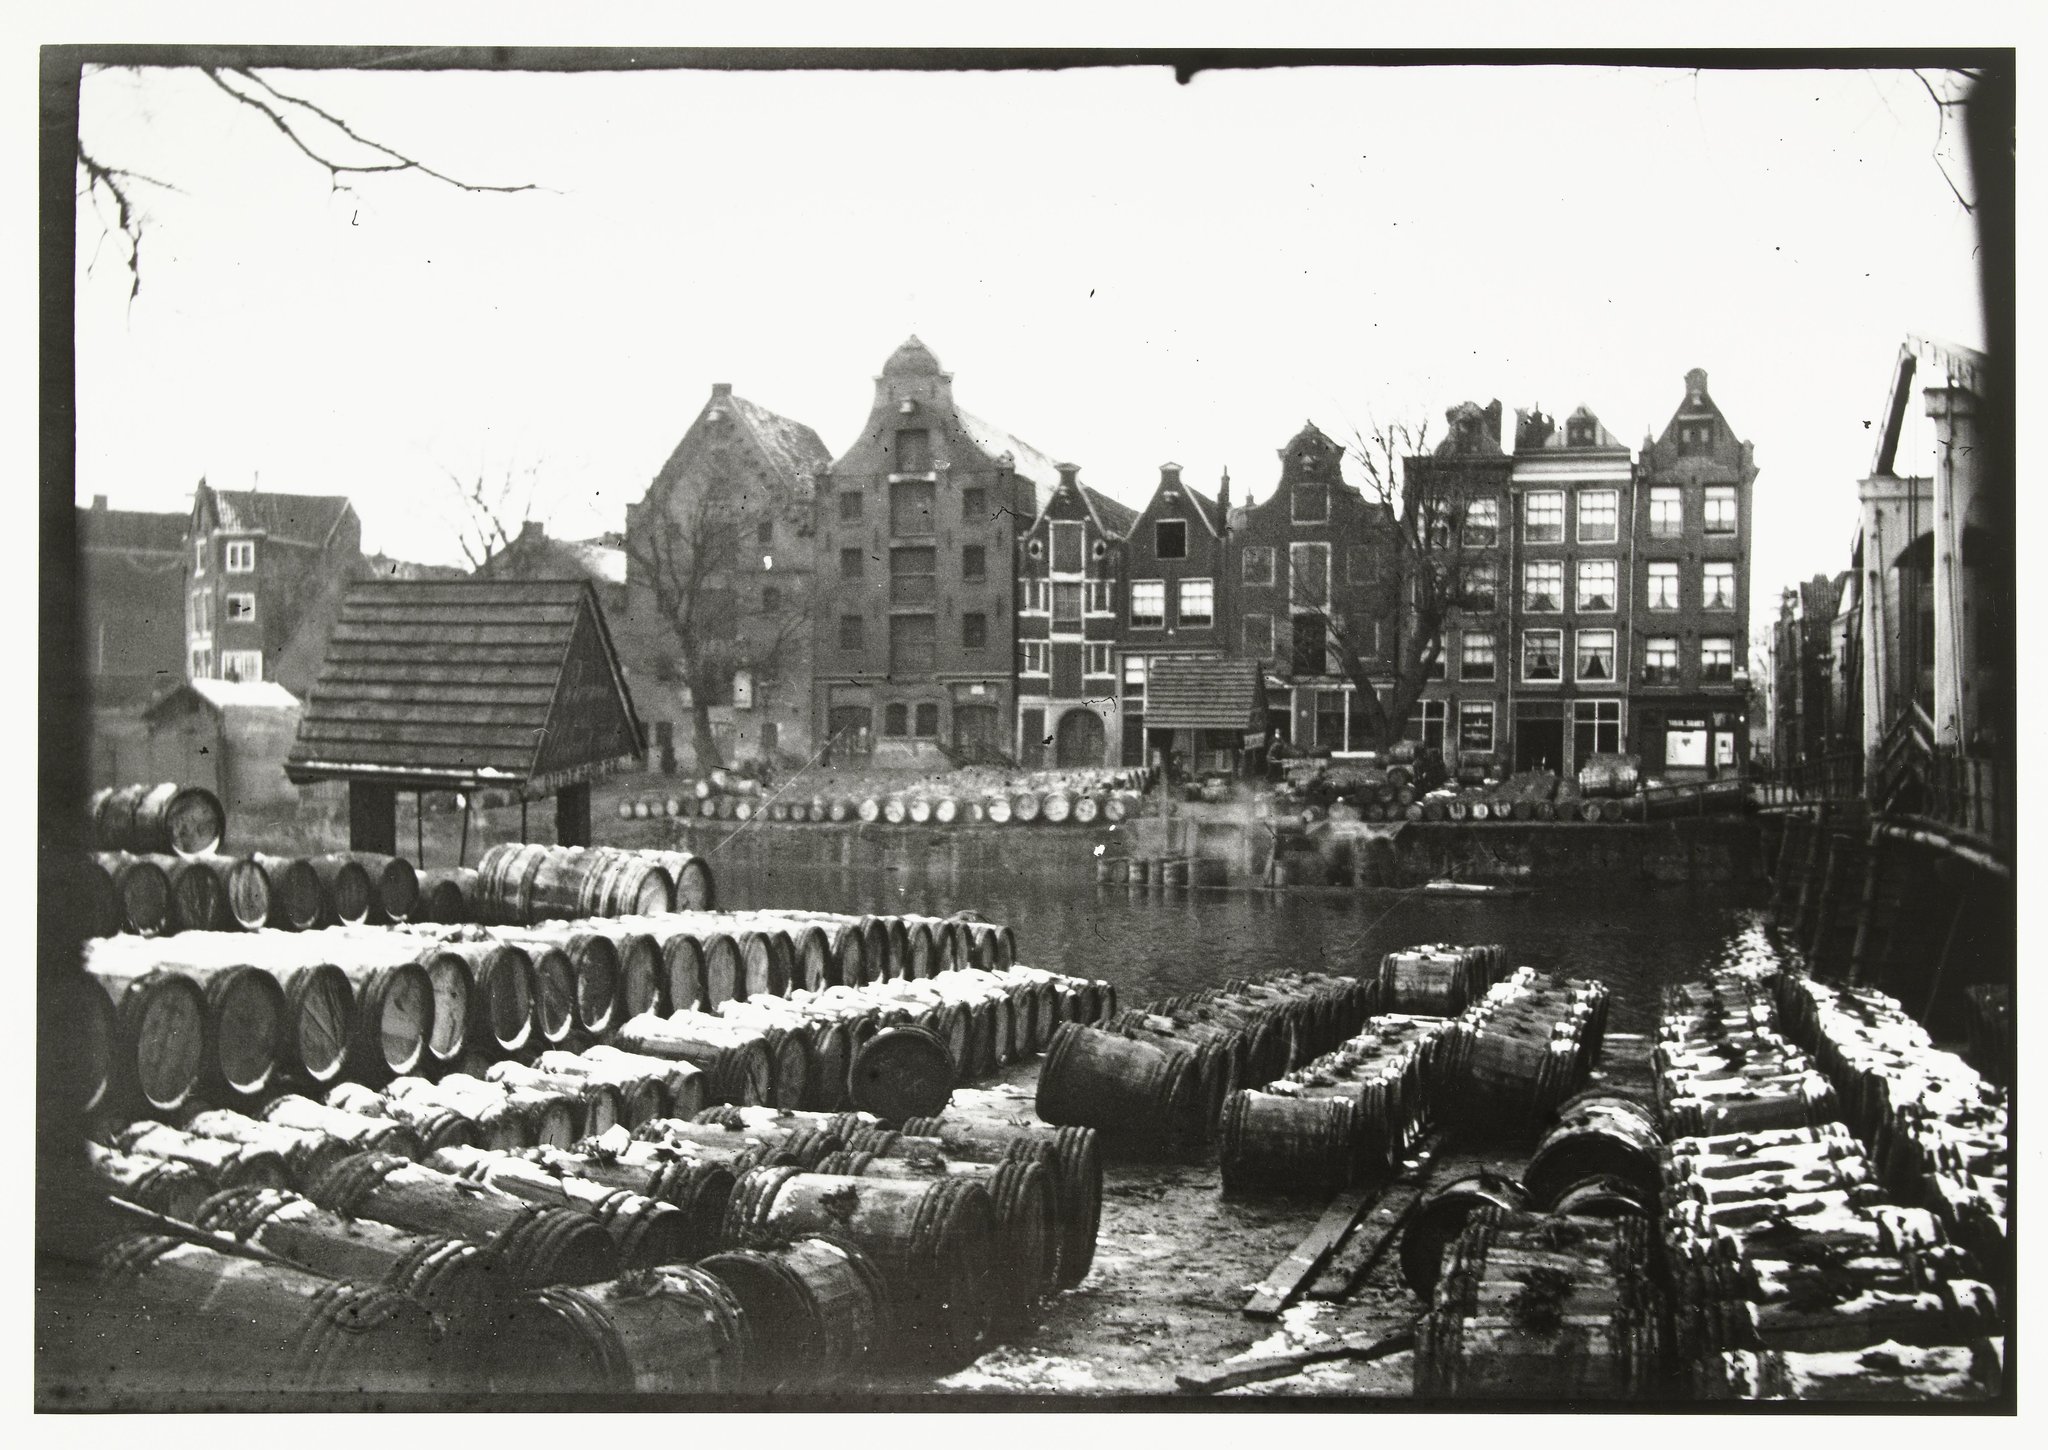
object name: photograph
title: Gezicht op de Teertuinen op het Prinseneiland in Amsterdam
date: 1890-1910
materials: paper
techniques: gelatin silver print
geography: netherlands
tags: nieuwe teertuinen, prinseneiland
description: Moderne afdruk van negatief BR 216 (collectie RKD).